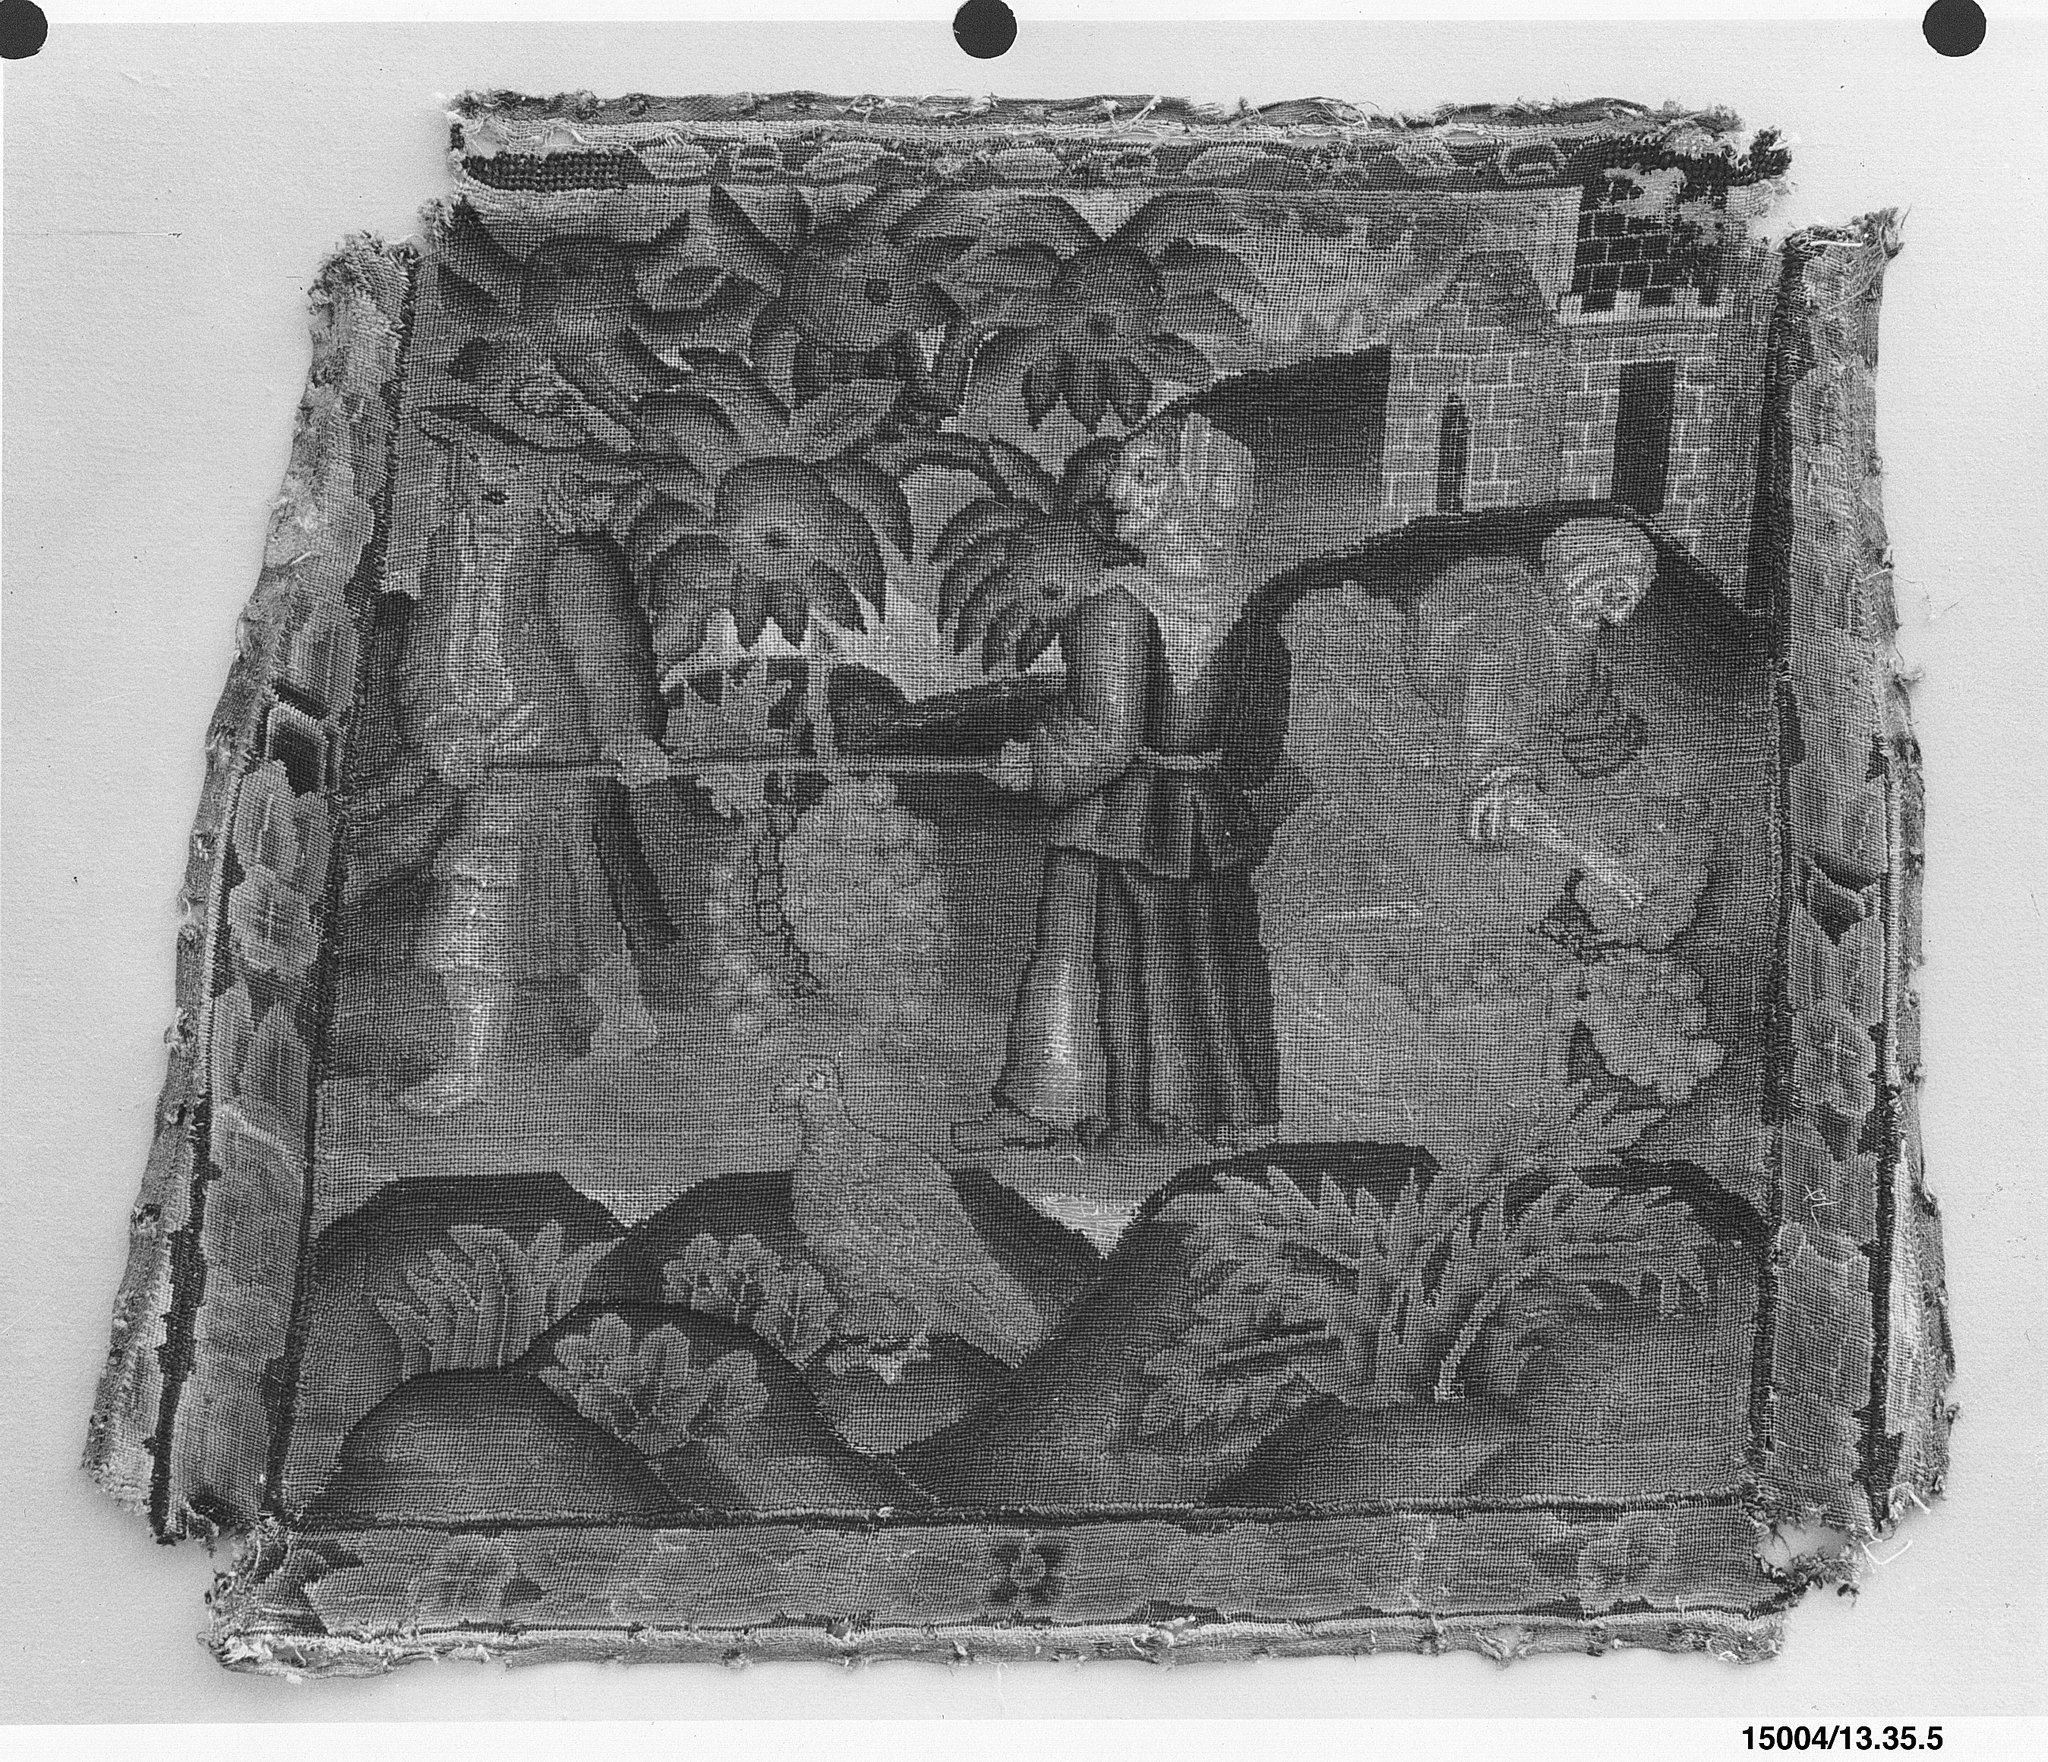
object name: cover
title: Chair seat cover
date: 1701-1800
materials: silk, wool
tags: birds,grapes,women,flowers